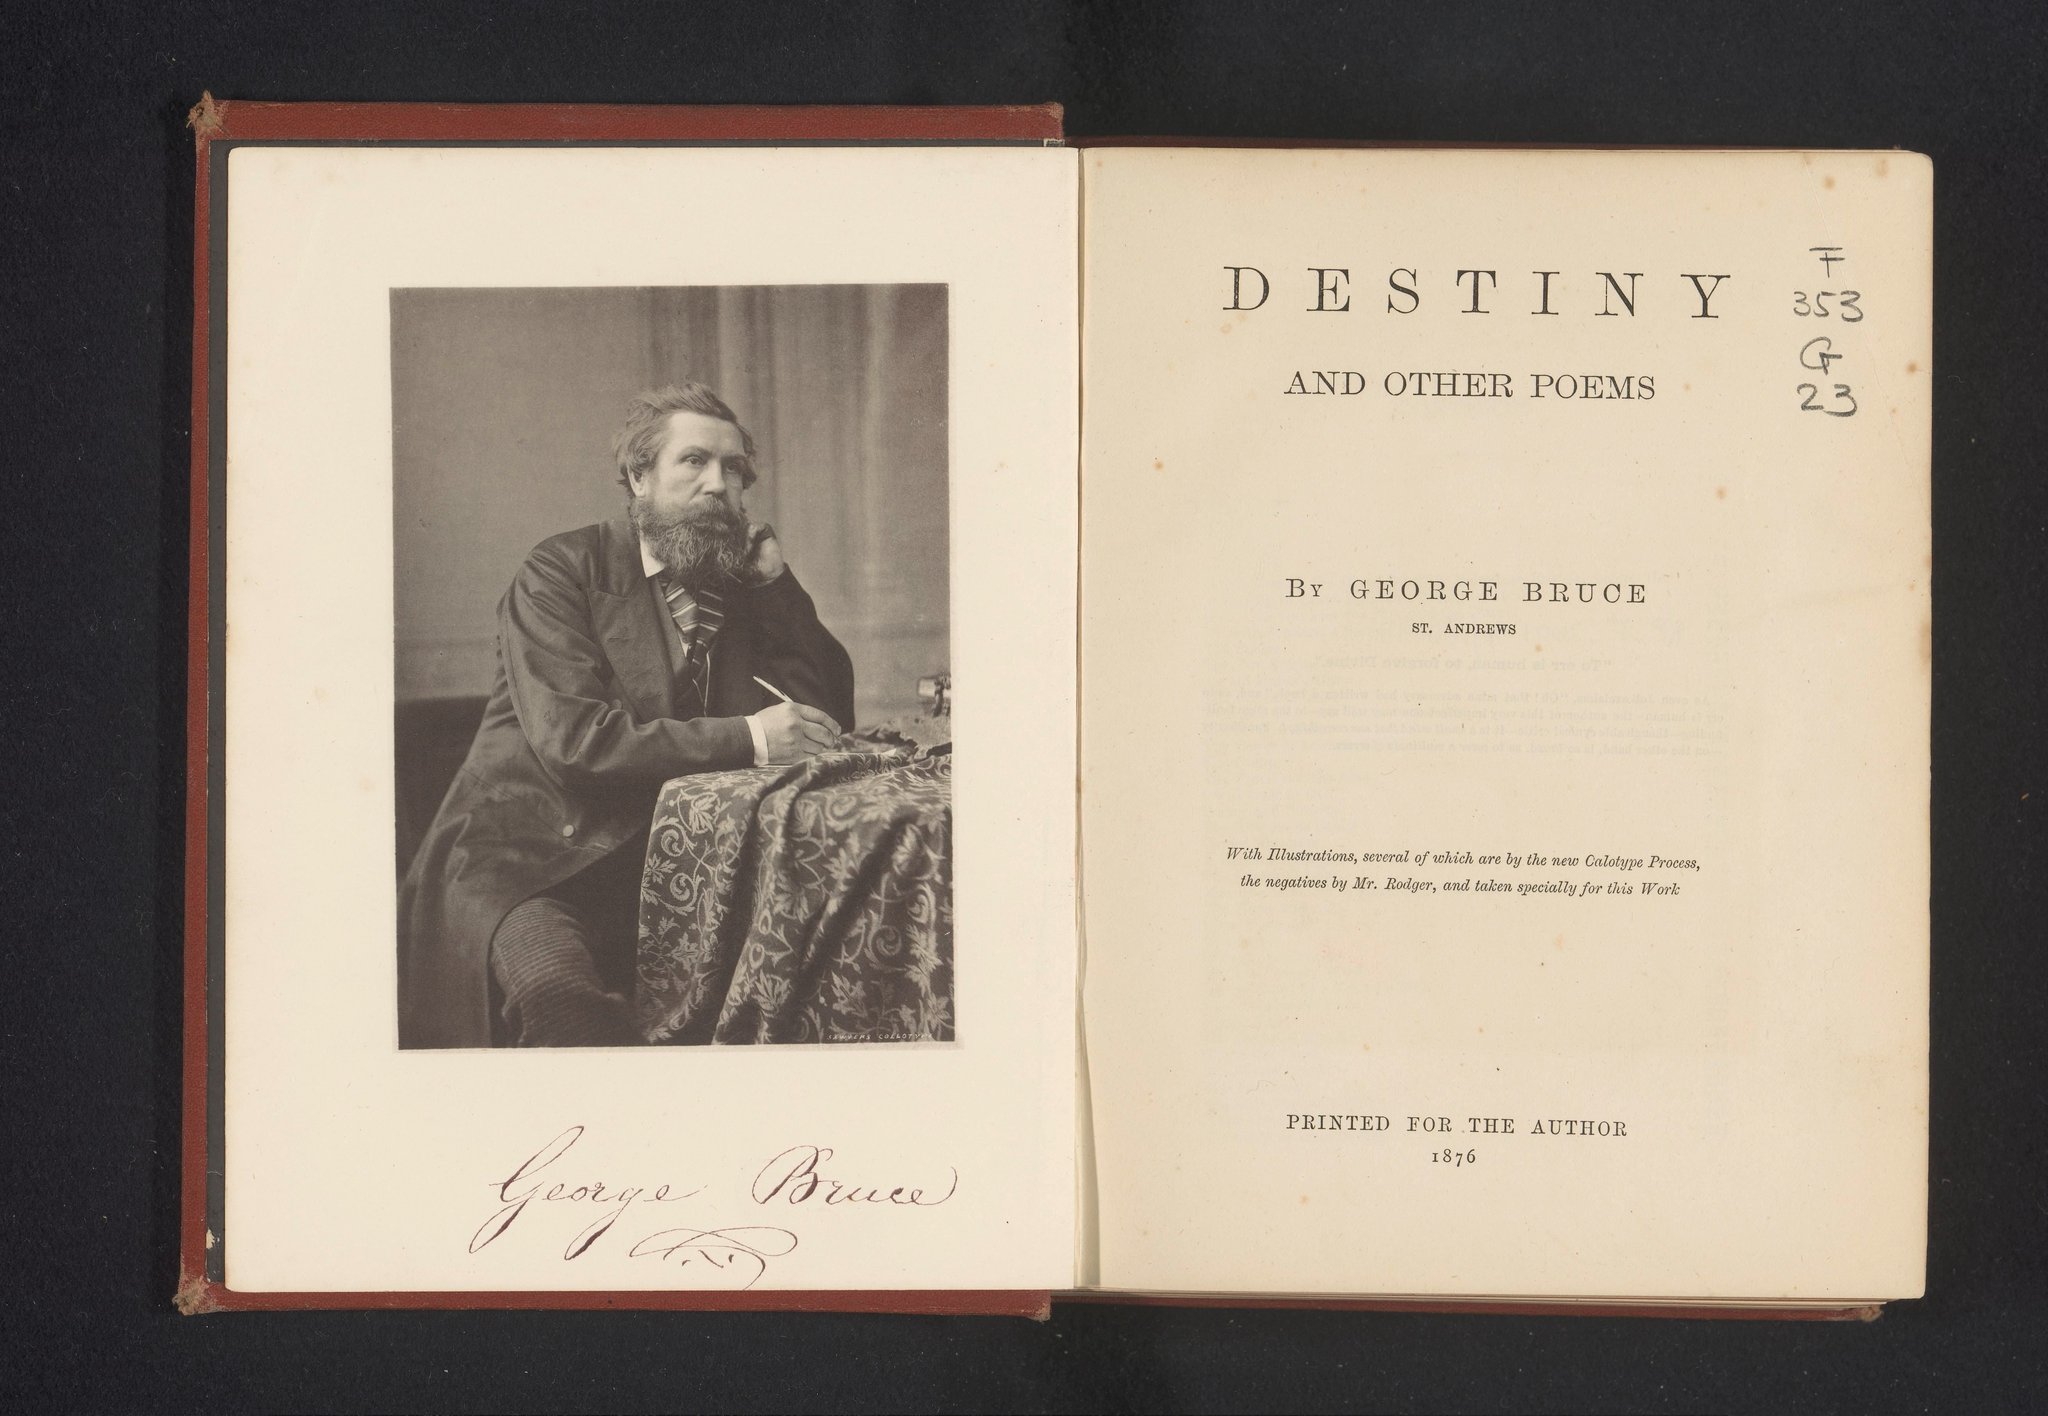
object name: book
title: Destiny and other poems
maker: george bruce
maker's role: dichter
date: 1876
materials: linen, paper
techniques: photograph, printing